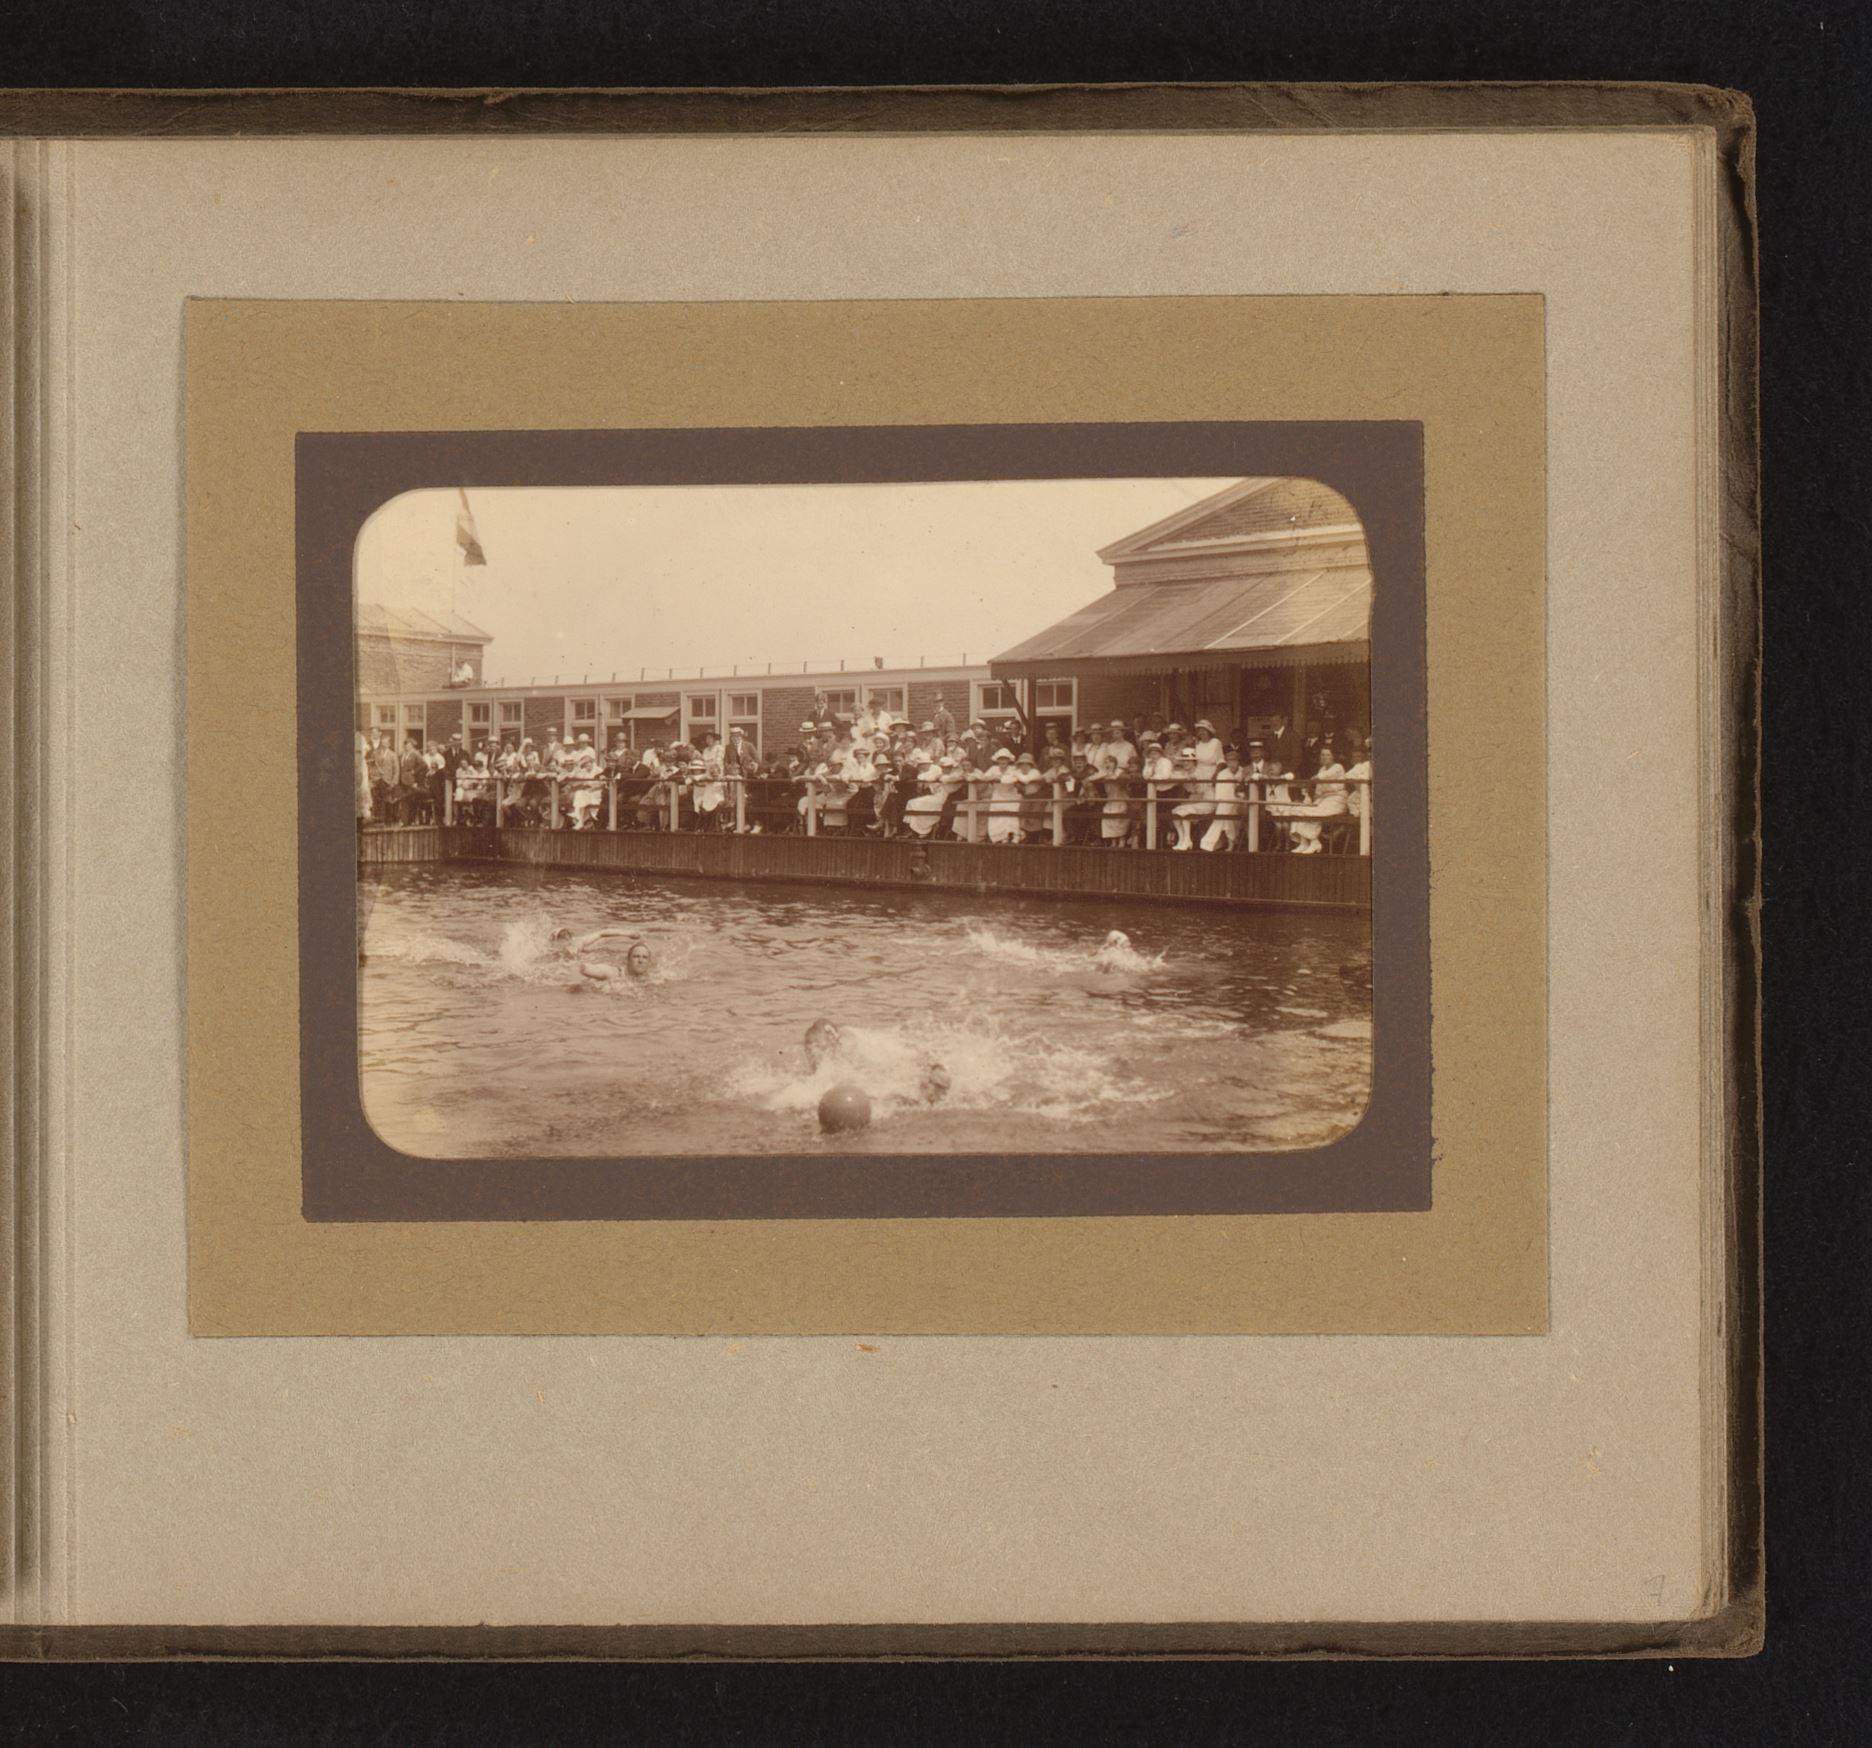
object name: album leaf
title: Publiek bij een wedstrijd van waterpolo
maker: Anonymous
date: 1900-1930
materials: photographic support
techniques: matte daylight collodion silver print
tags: water polo, historical persons